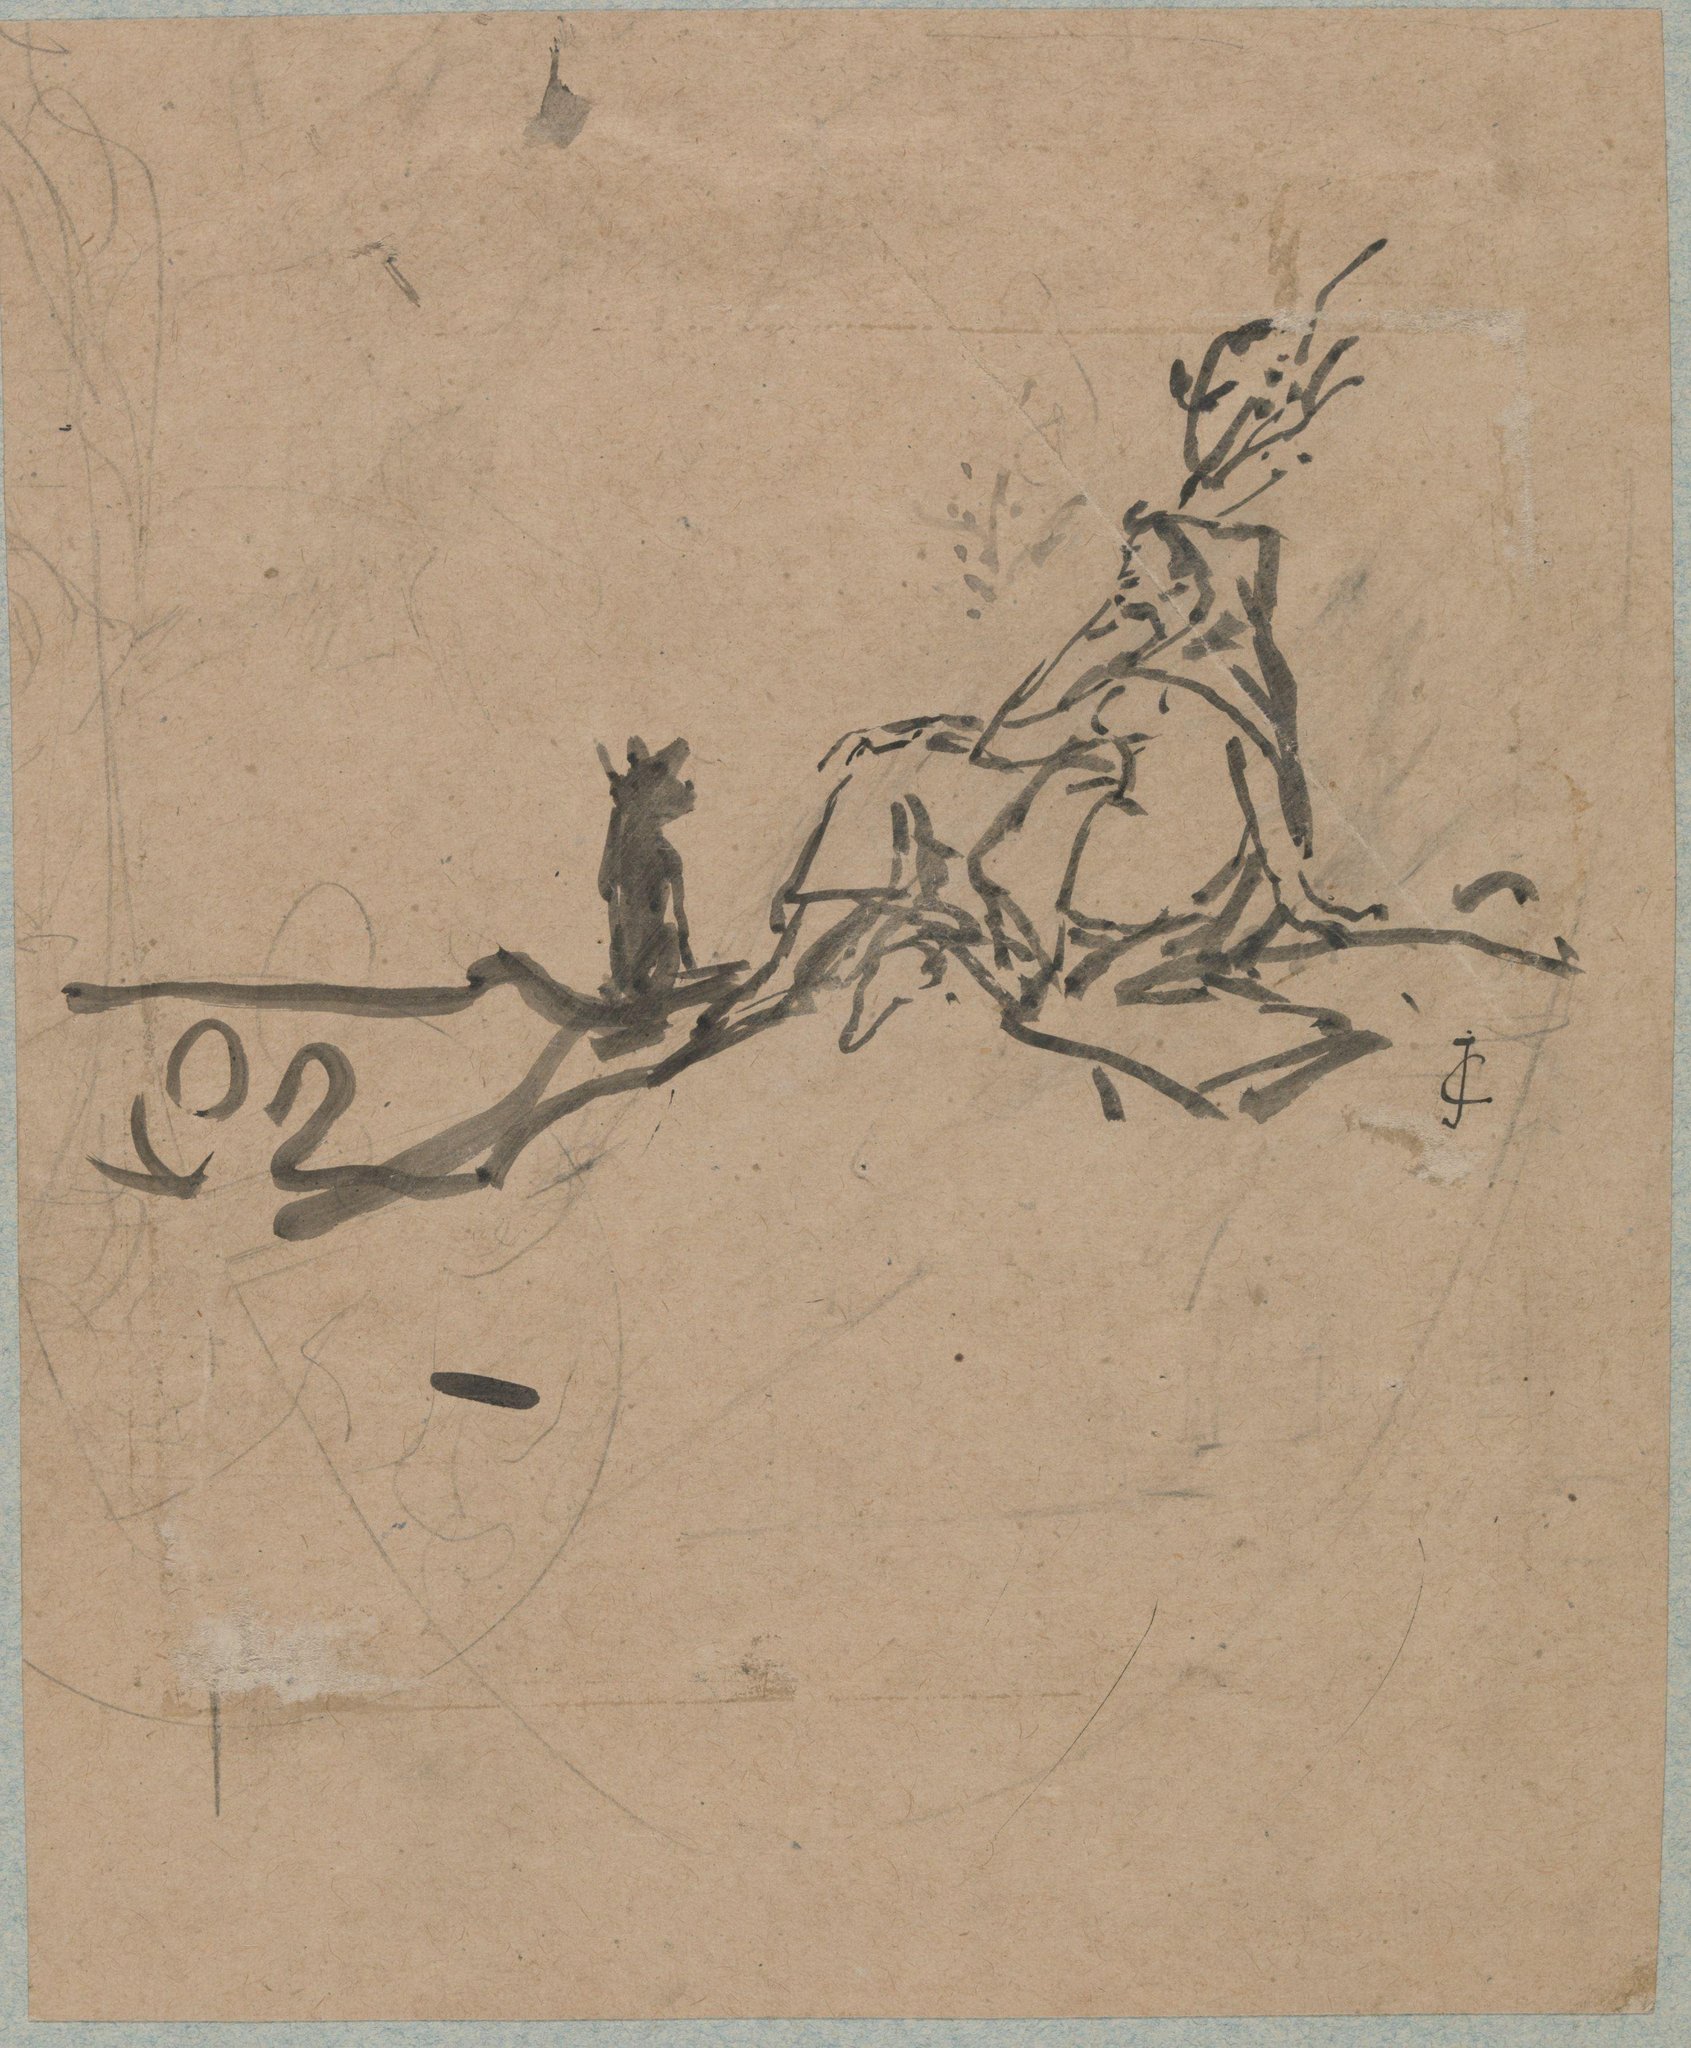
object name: design drawing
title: Zittende figuur met hond bij boom (op vaaslichaam?)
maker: gustave joseph chéret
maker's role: sculptor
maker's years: 1838-1894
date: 1870-1894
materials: cardboard, graphite, ink, paper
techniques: brush, pen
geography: paris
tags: sitting figure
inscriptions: monogram: ‘JC’, inscription: ‘Le repos’, label: ‘696’, workshop stamp: ‘Joseph Chéret’